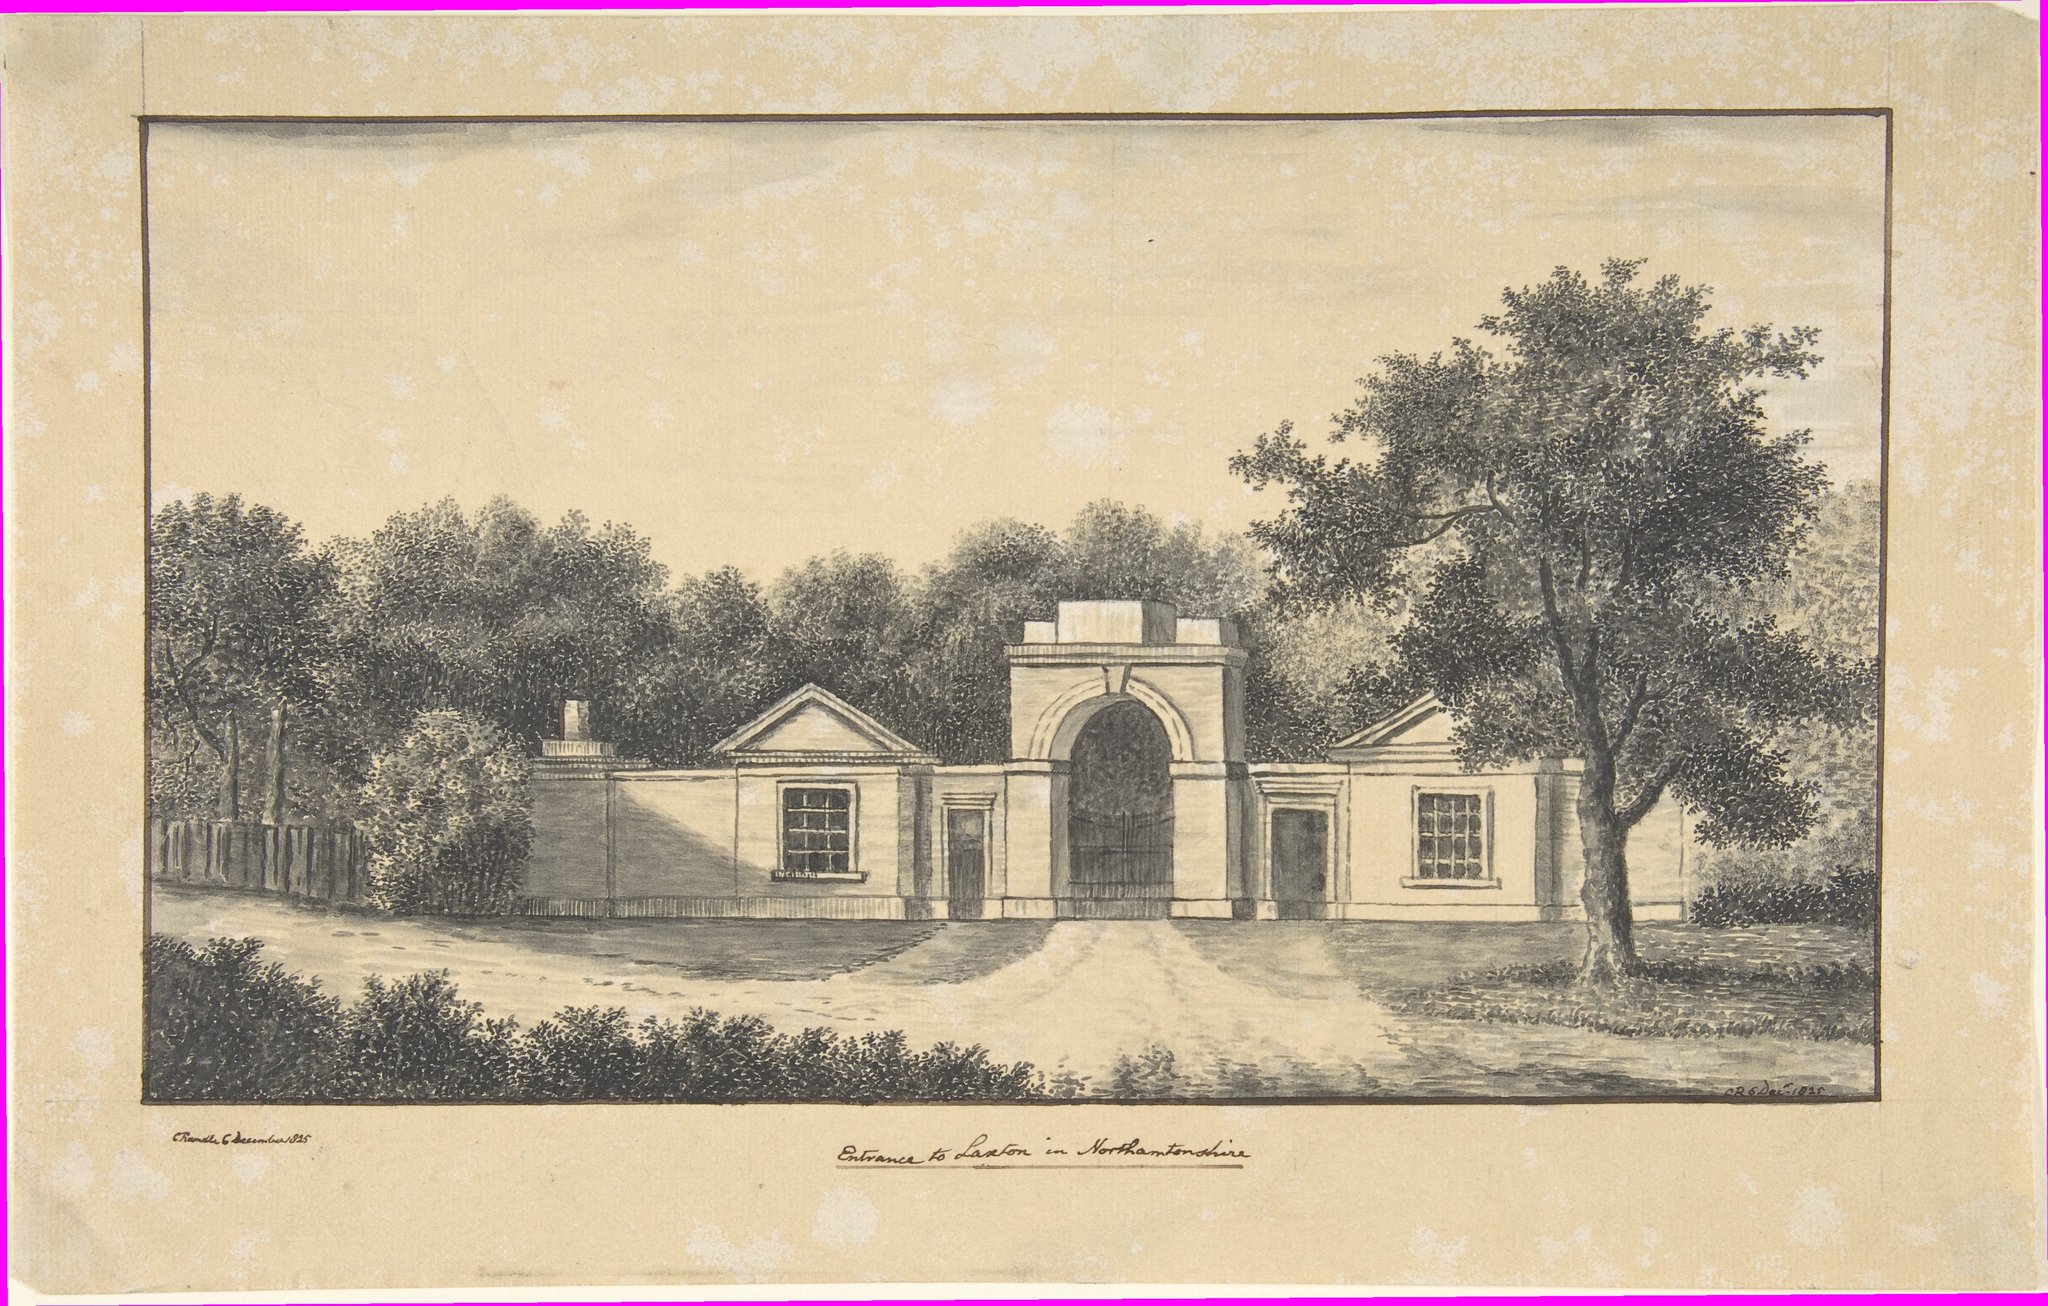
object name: drawing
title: Entrance to Laxton in Northamptonshire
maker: charles randle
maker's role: artist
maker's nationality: british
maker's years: 1800-1900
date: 1825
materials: ink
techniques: brush, pen, wash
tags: doorways,villages,trees